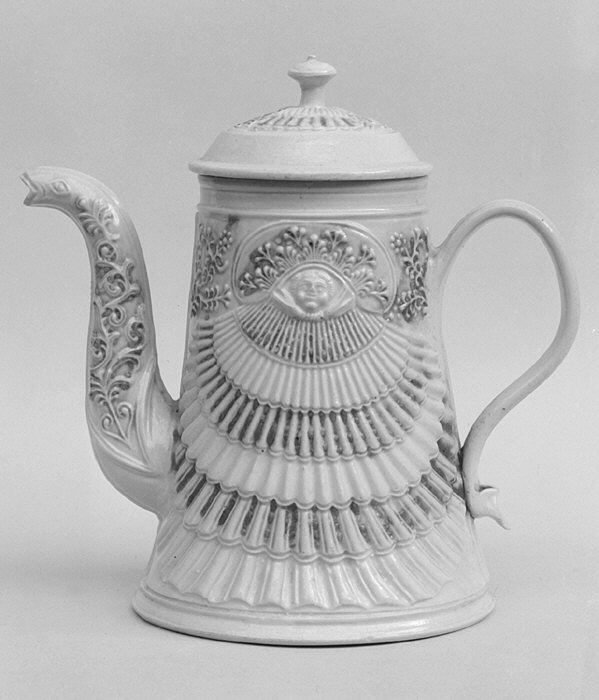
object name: coffeepot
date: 1750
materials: stoneware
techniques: salt glaze